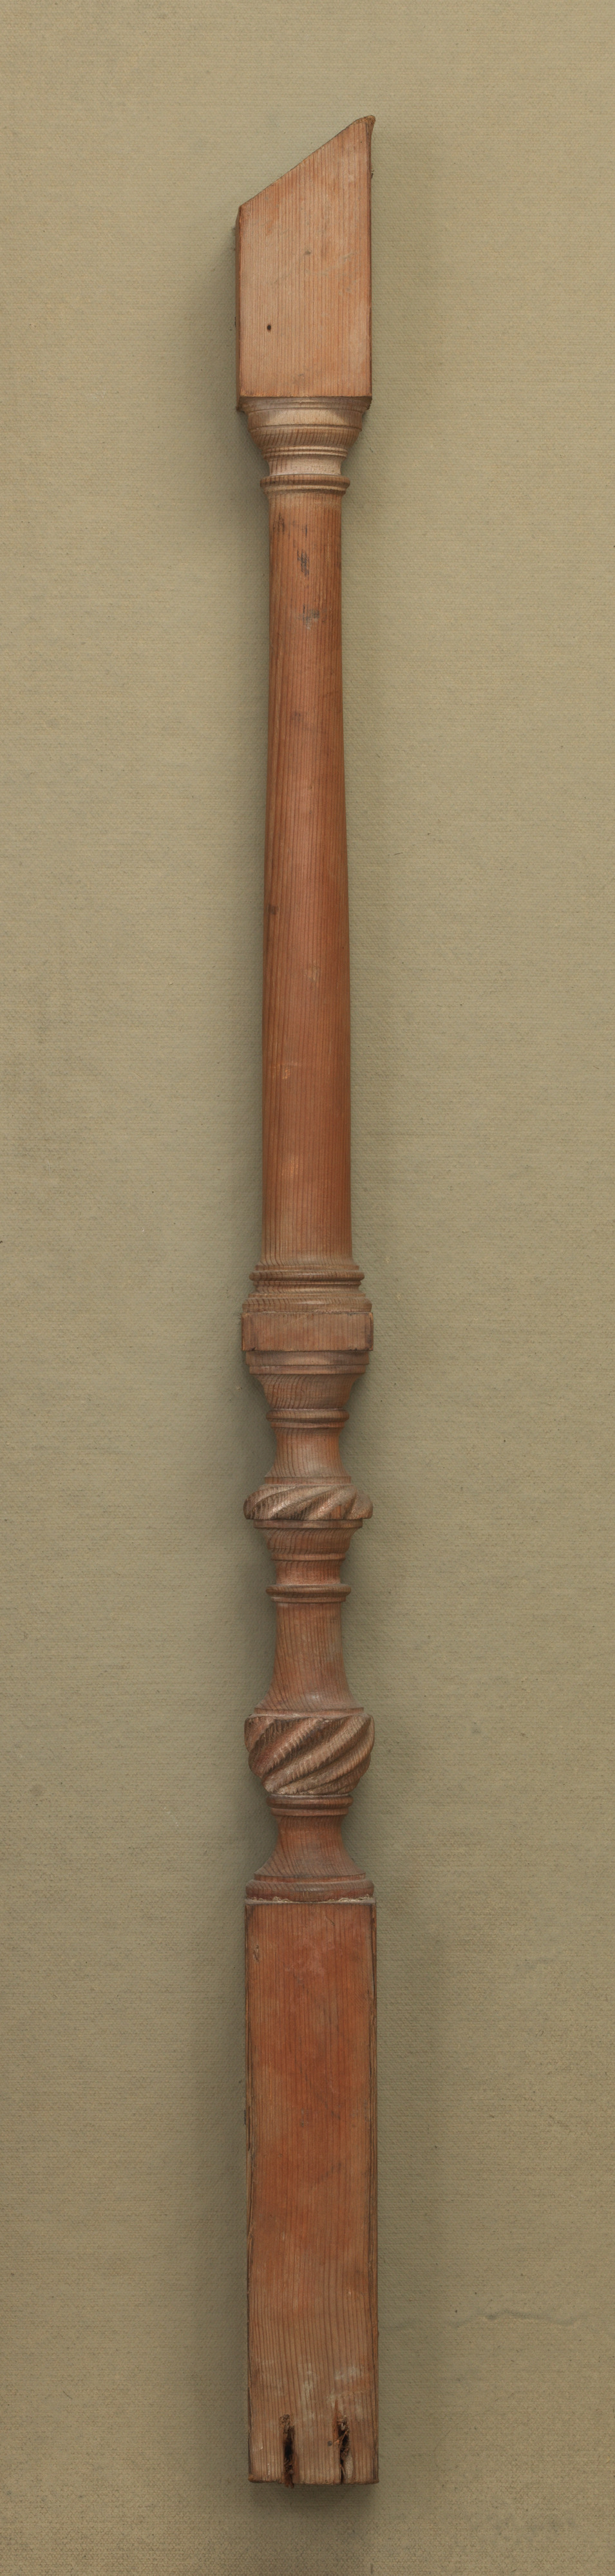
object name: baluster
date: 1734-1766